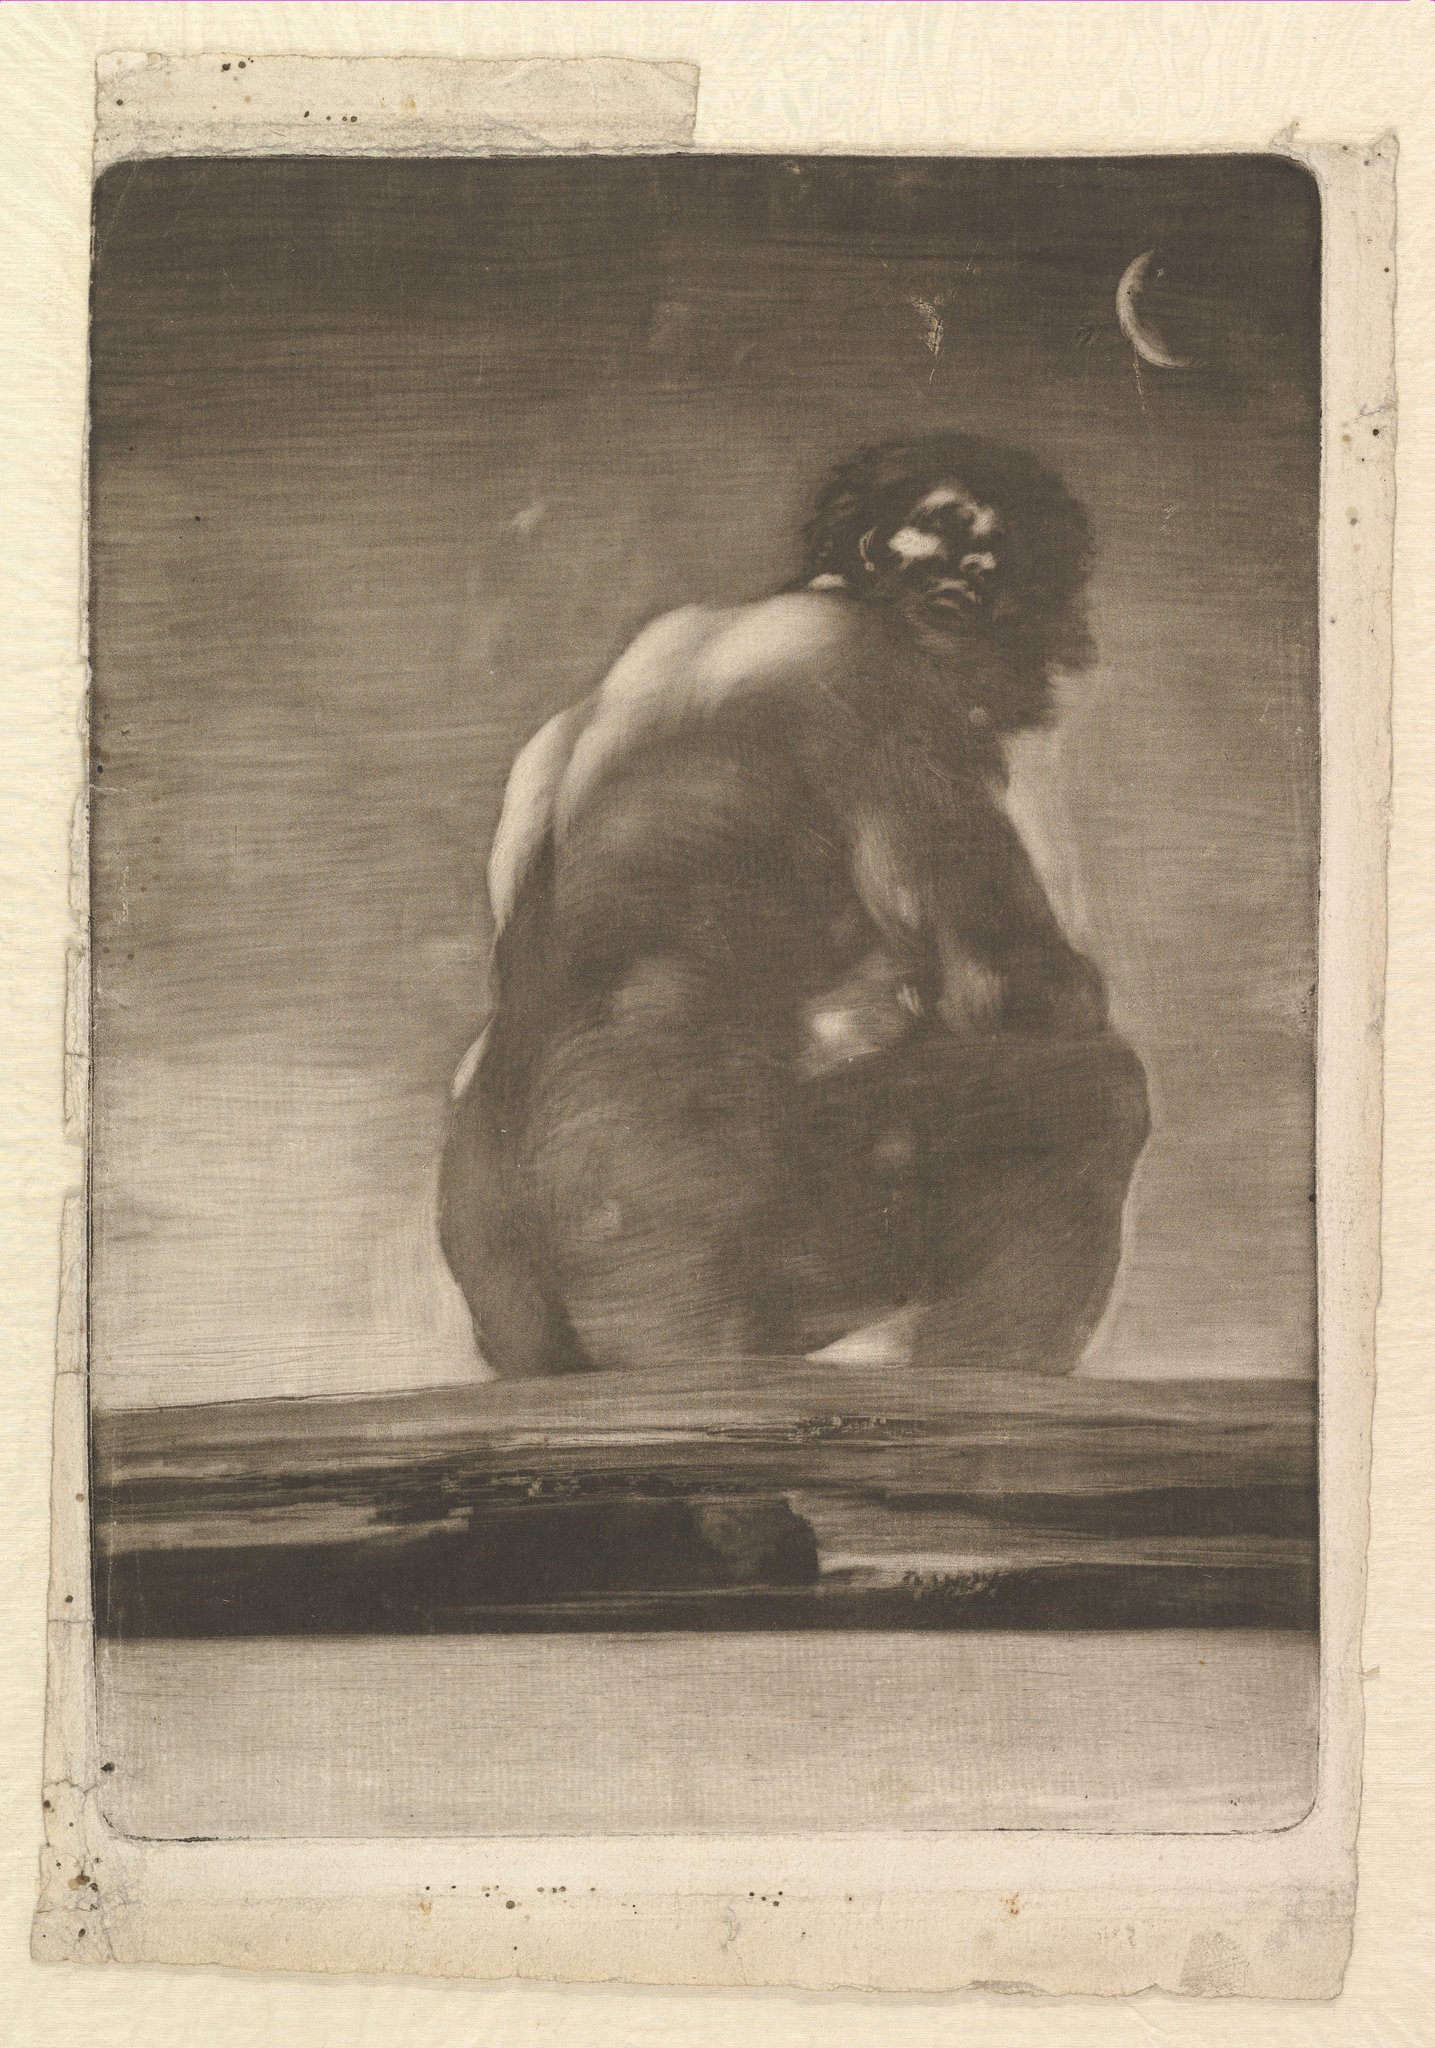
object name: print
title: Seated Giant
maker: goya (francisco de goya y lucientes)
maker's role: artist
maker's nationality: spanish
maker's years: 1746-1828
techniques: aquatint, burnishing, roulette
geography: spain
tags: men,male nudes